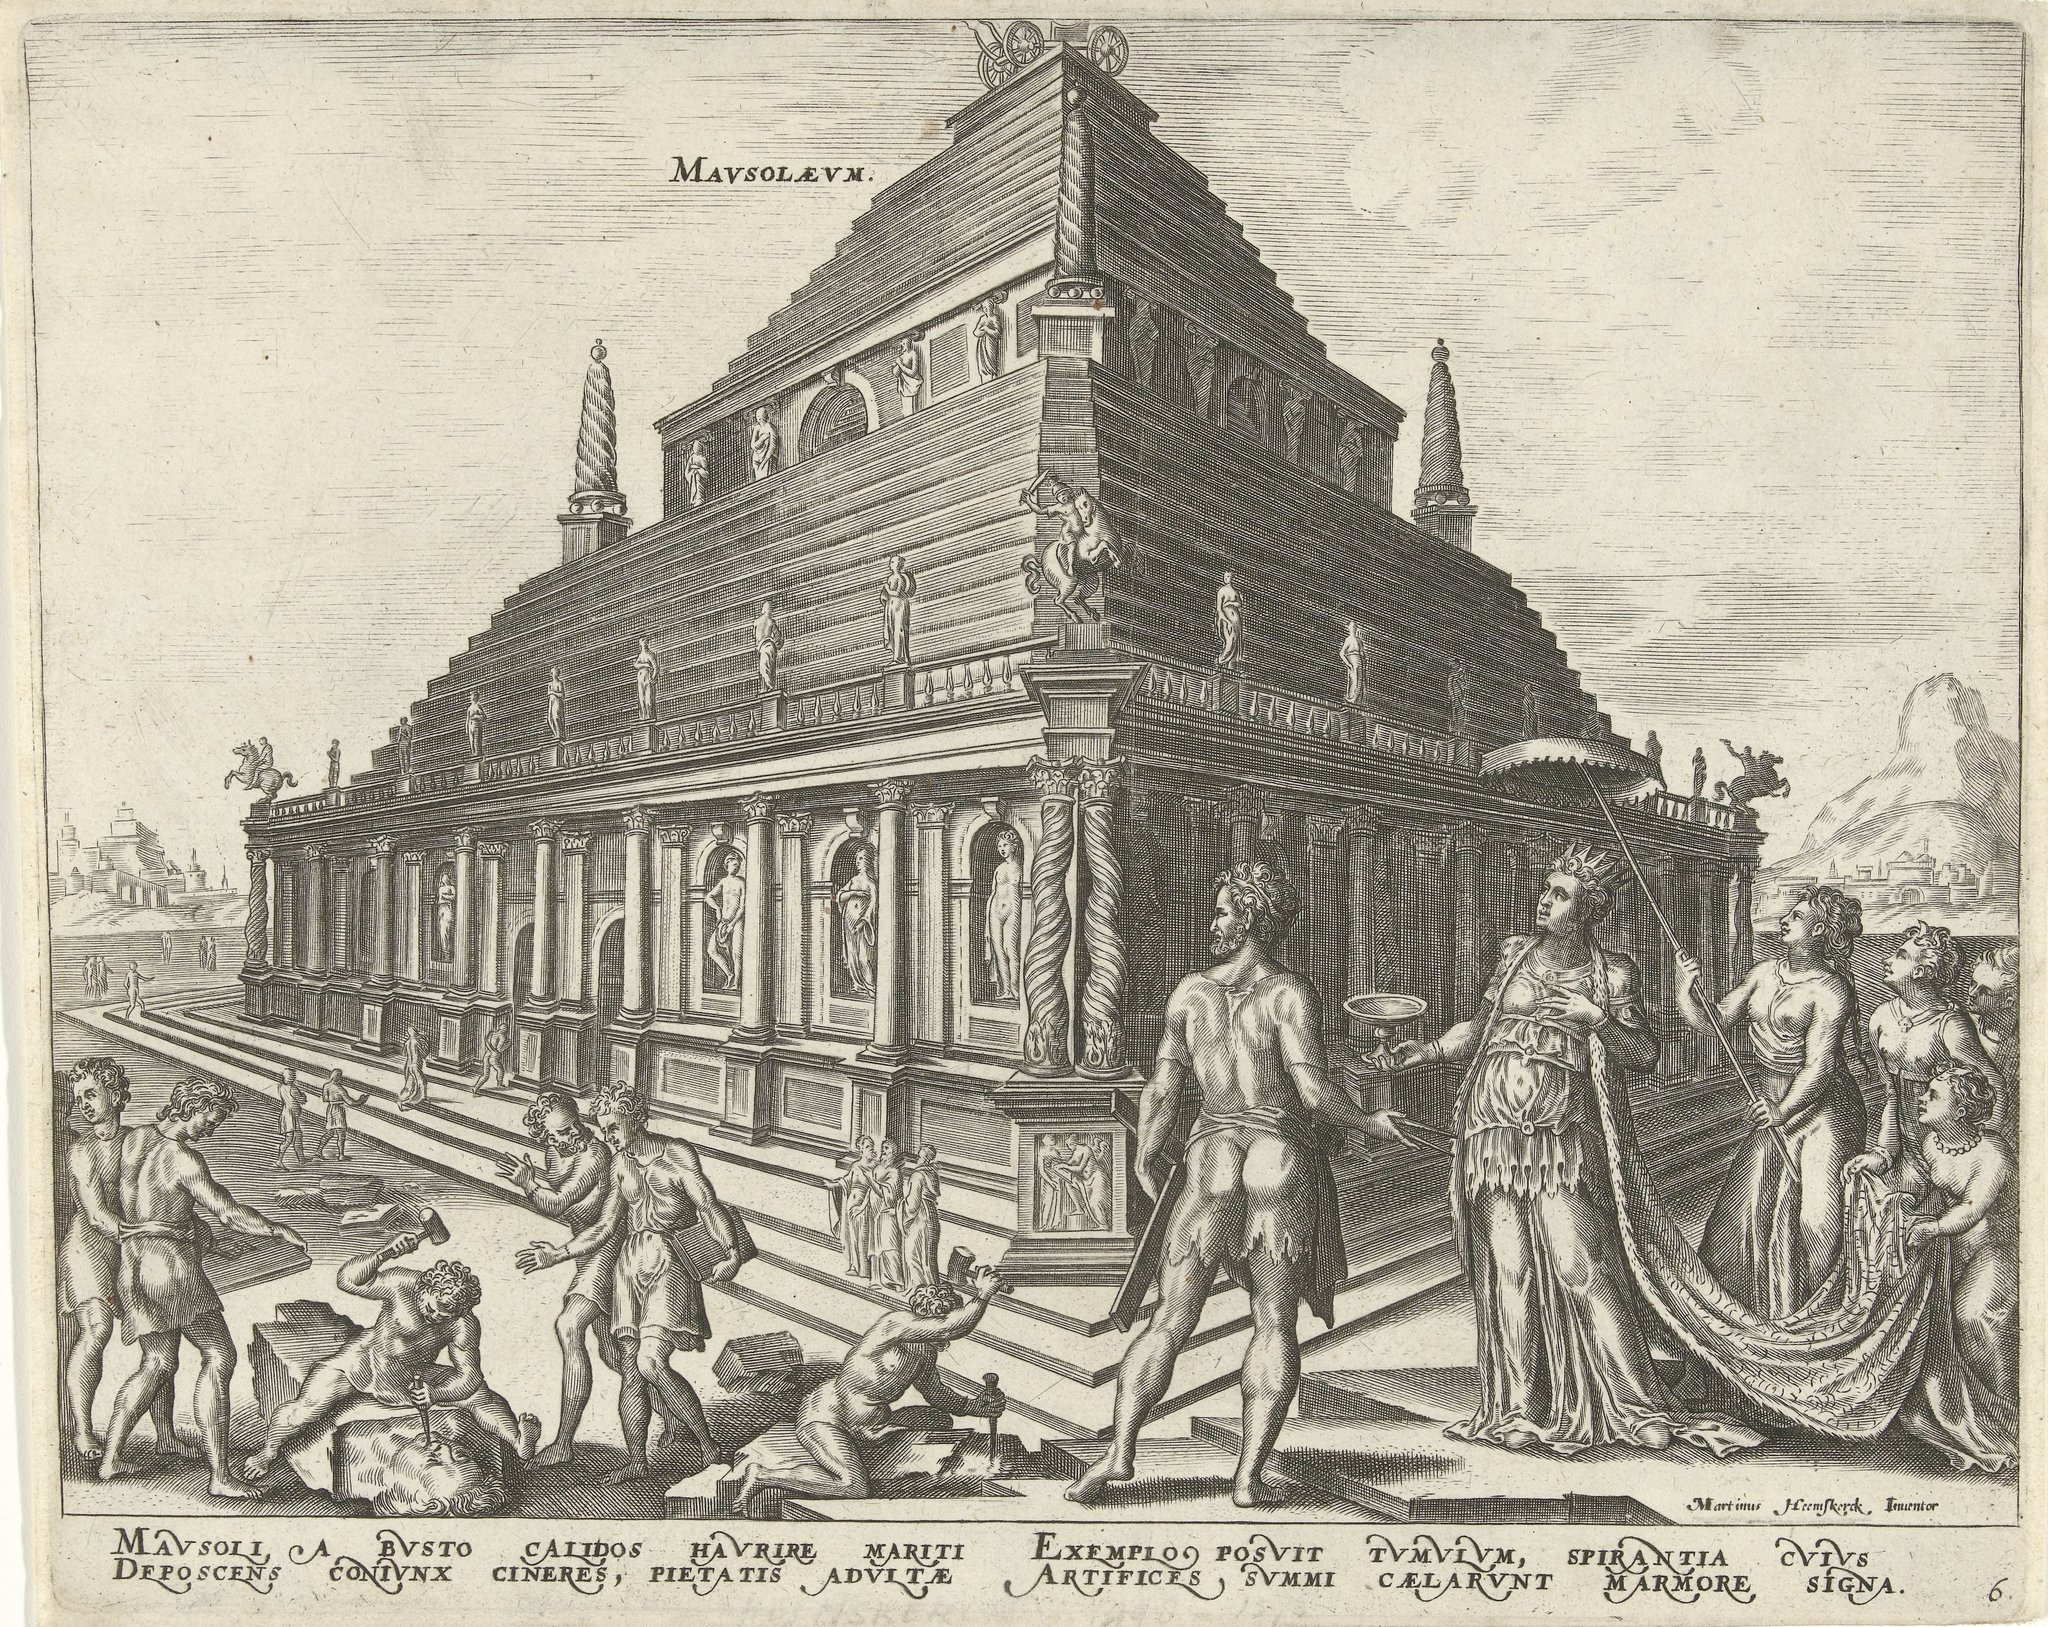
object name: print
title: De acht wereldwonderen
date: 1572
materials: paper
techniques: engraving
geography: haarlem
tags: sculptor at work, artemisia erects a monument to the memory of her dead husband, mausoleum at halicarnassus (wonder of the world)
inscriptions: collector's mark: Lugt 2228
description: Het mausoleum van Halicarnasse, de graftombe van koning Mausolus, een Perzische stadsvorst van Halicarnassus uit de 4e eeuw v. Chr. Het werd na zijn dood in 353 v. Chr. gebouwd in opdracht van zijn weduwe, koningin Artemisa. Het graf heeft een rechthoekige vorm en bovenop het bouwsel staat een strijdwagen. Op de voorgrond de koningin onder een parasol, begeleid door bedienden. Linksvoor zijn beeldhouwers een kop aan het hakken. De prent heeft een Latijns onderschrift en maakt deel uit van een serie over de acht wereldwonderen..